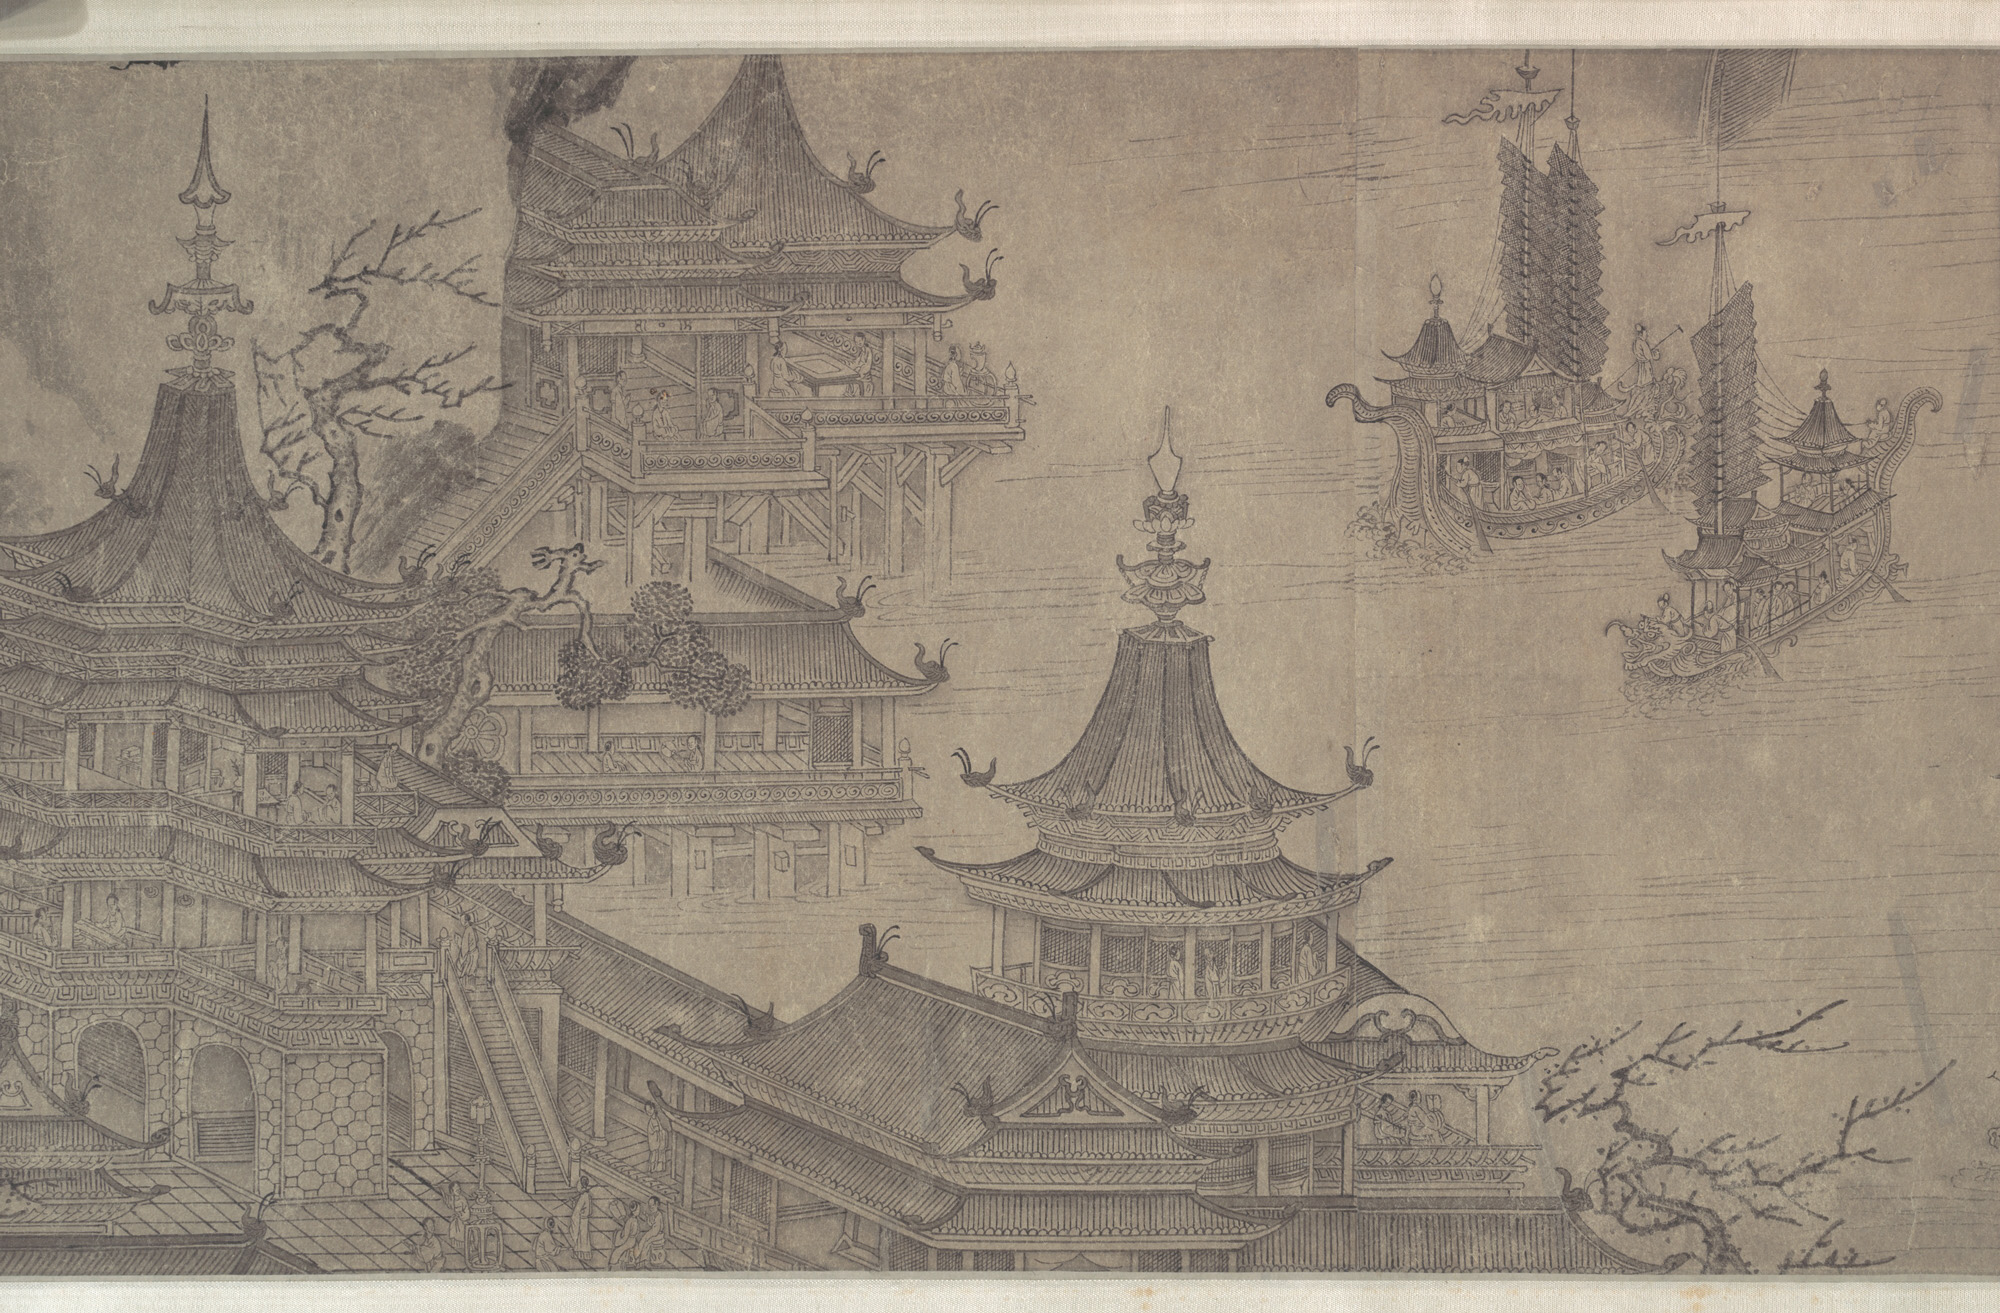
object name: handscroll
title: The Daming Palace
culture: chinese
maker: wang zhenpeng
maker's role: artist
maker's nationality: chinese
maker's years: 1265-1340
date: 1401-1433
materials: ink, paper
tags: palaces,boats